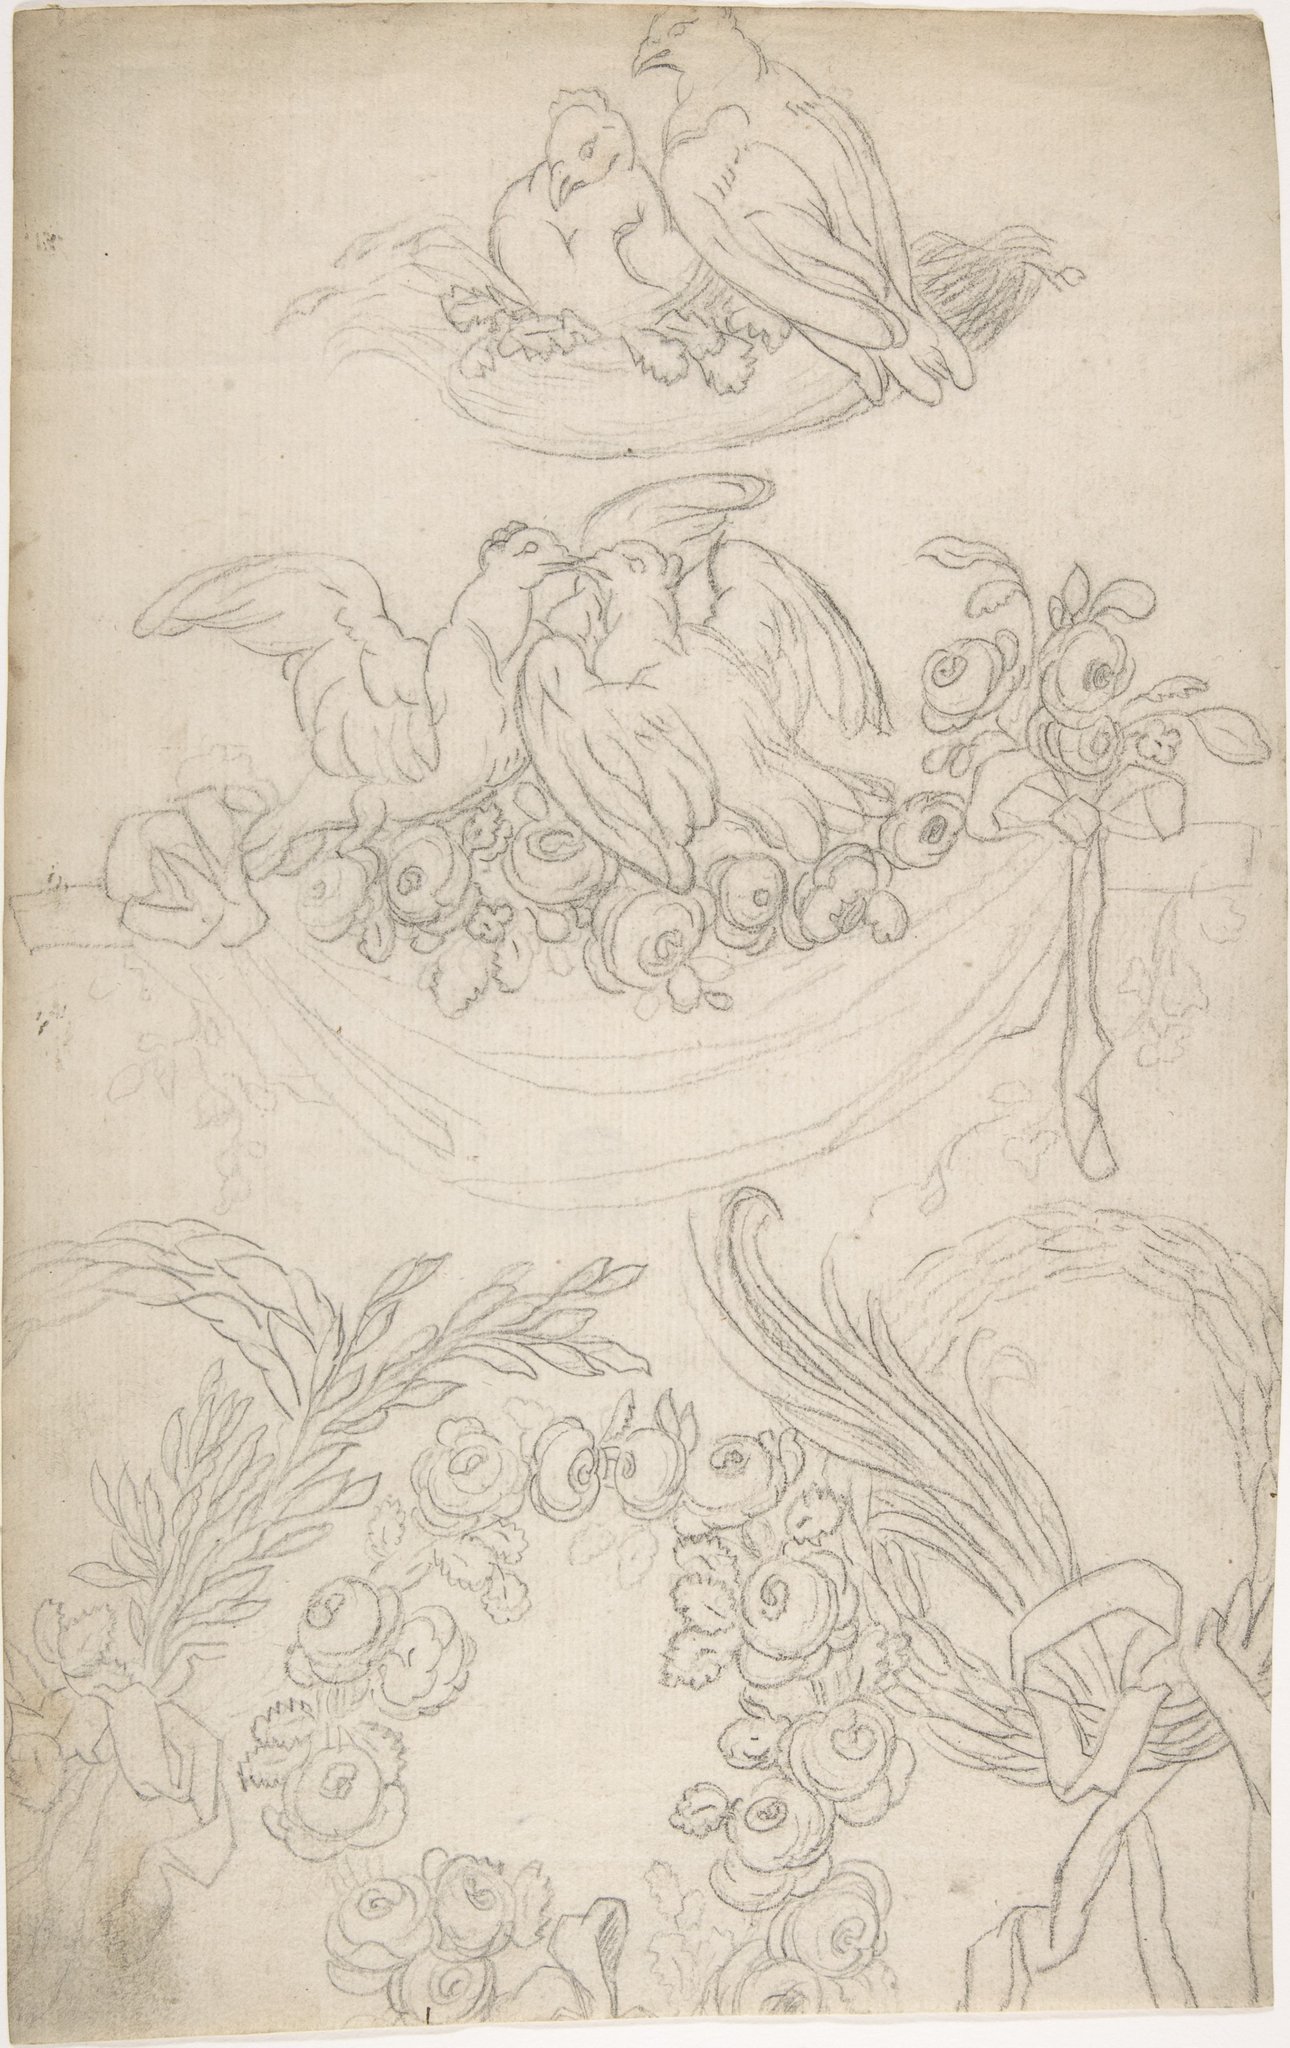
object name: drawing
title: Ornament with Doves and Cornucopia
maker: anonymous, german, 19th century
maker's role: artist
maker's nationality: german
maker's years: 1800-1899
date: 1780-1820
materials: crayon, graphite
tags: doves,flowers